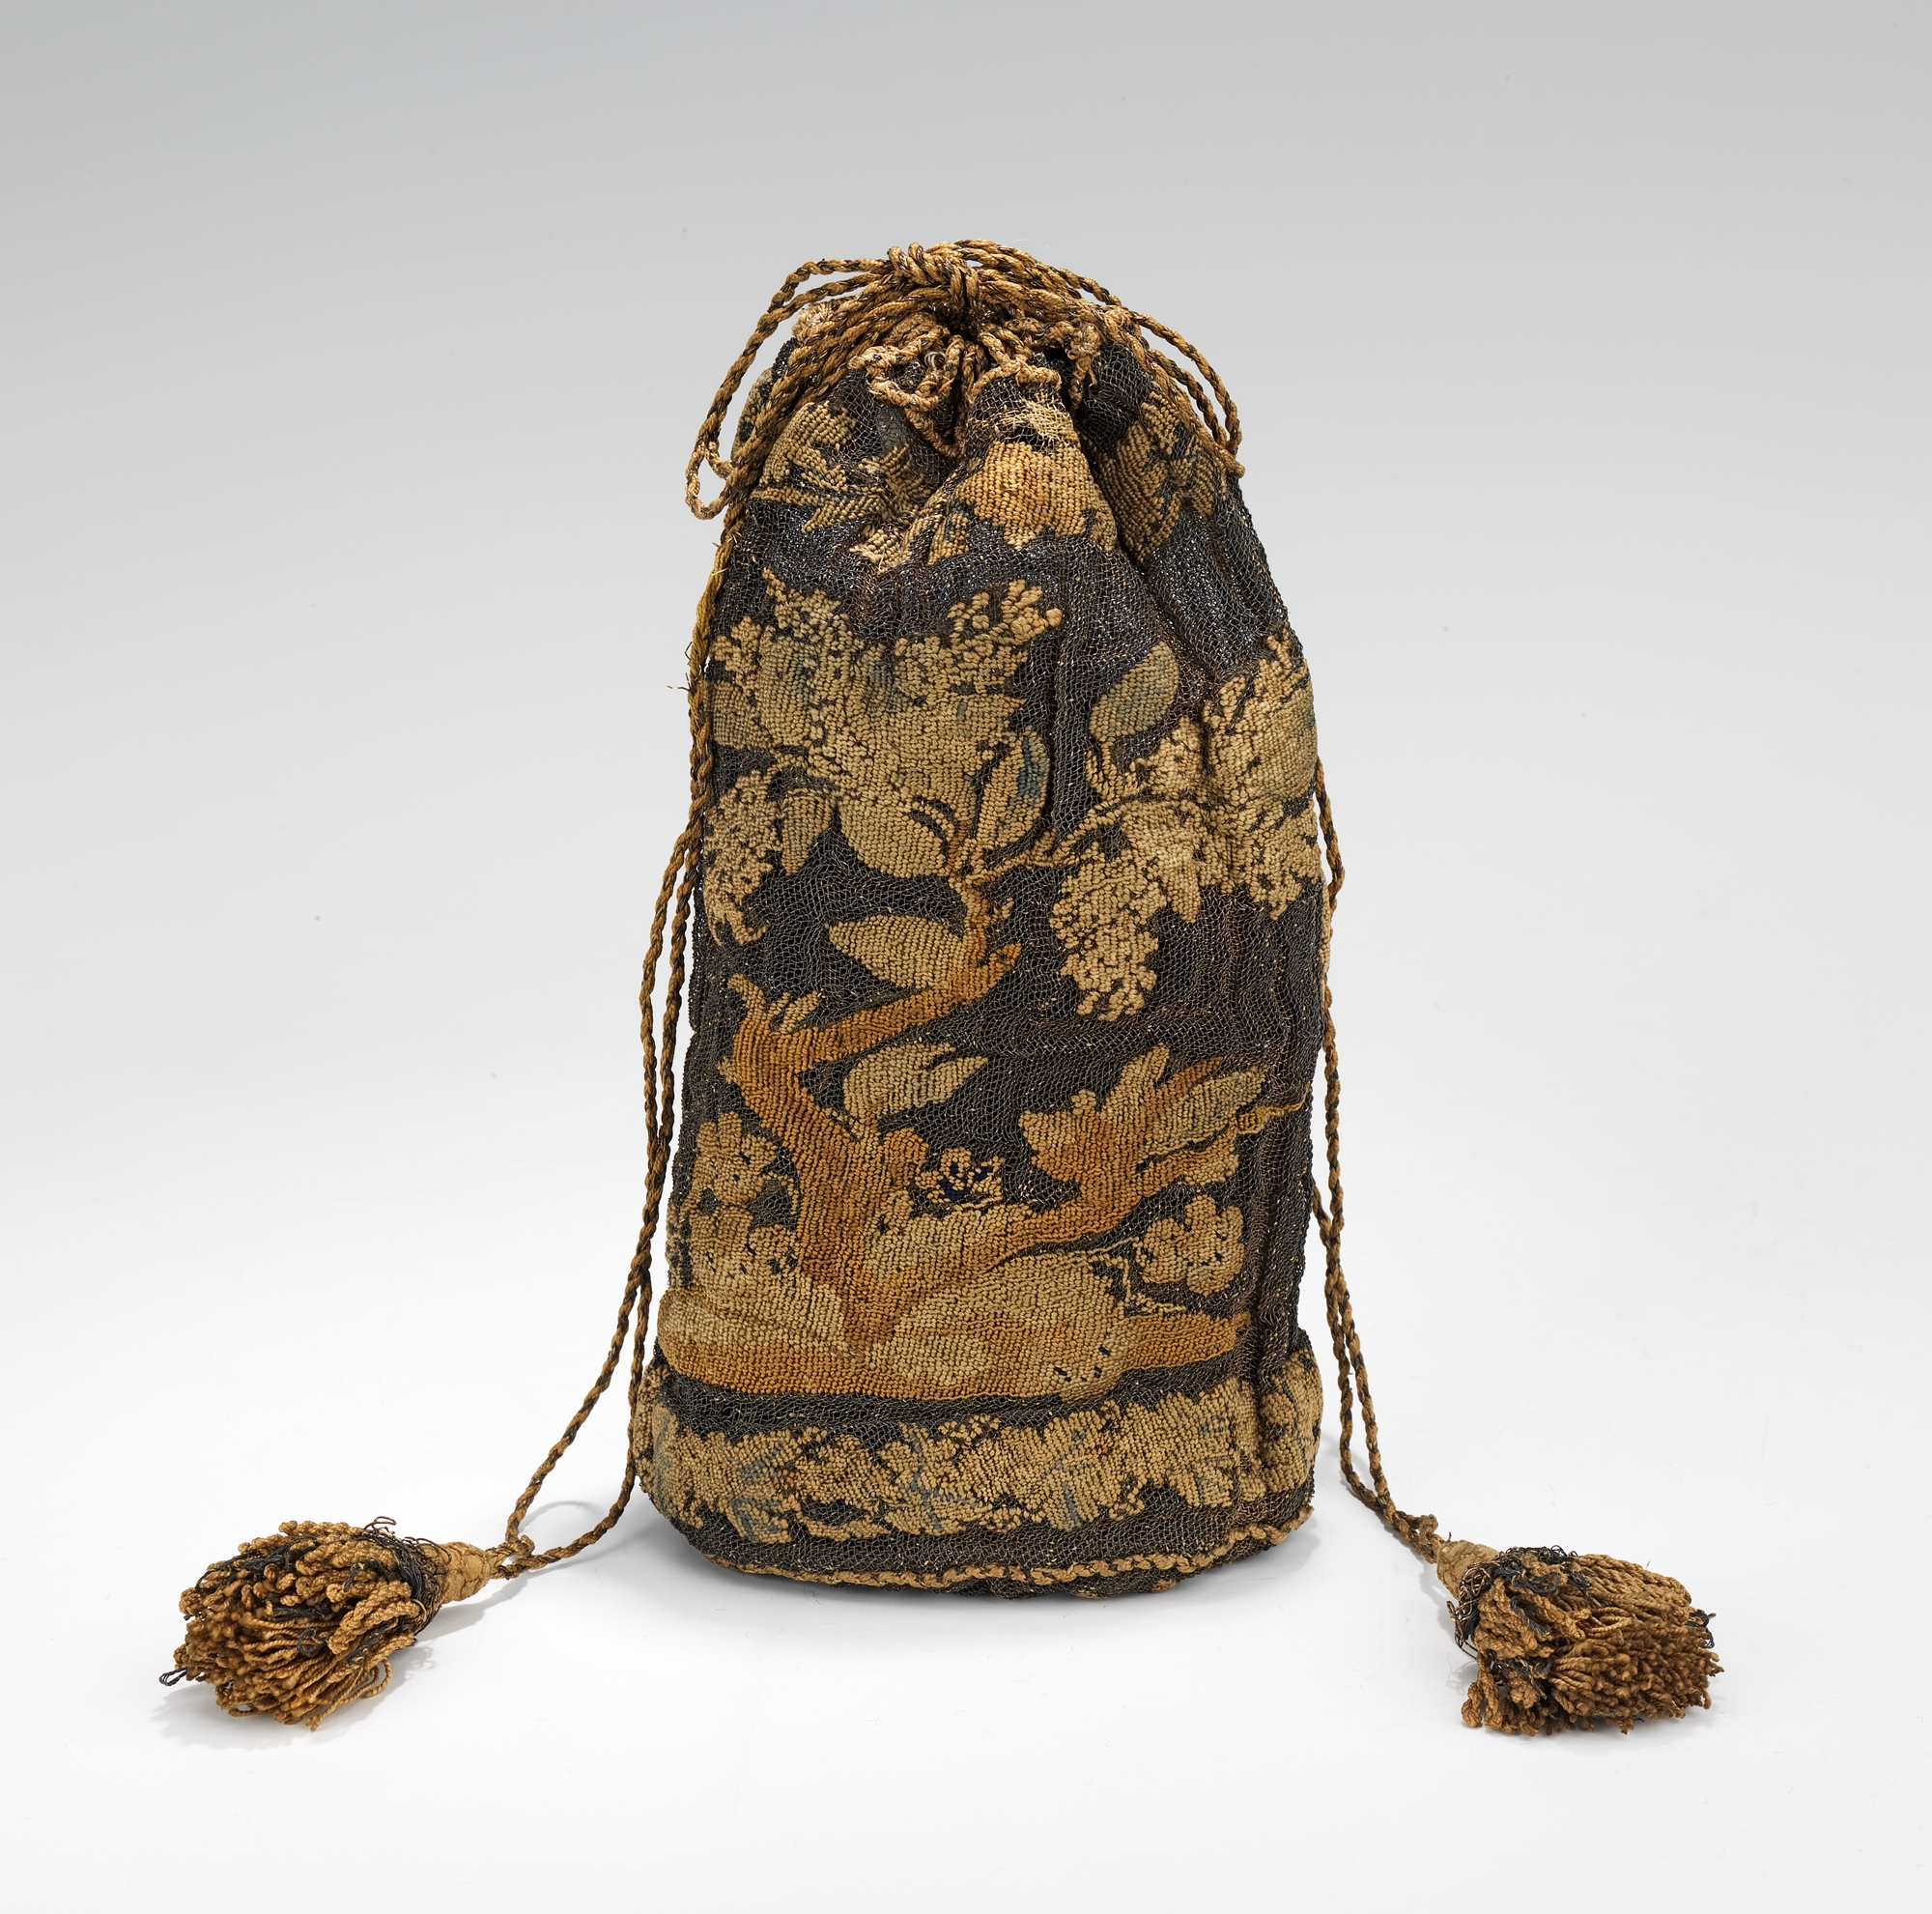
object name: pouch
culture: european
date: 1840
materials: metal, silk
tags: trees